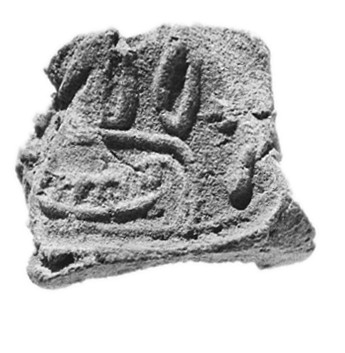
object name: sealing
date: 1981-1640 BCE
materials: mud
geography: egypt